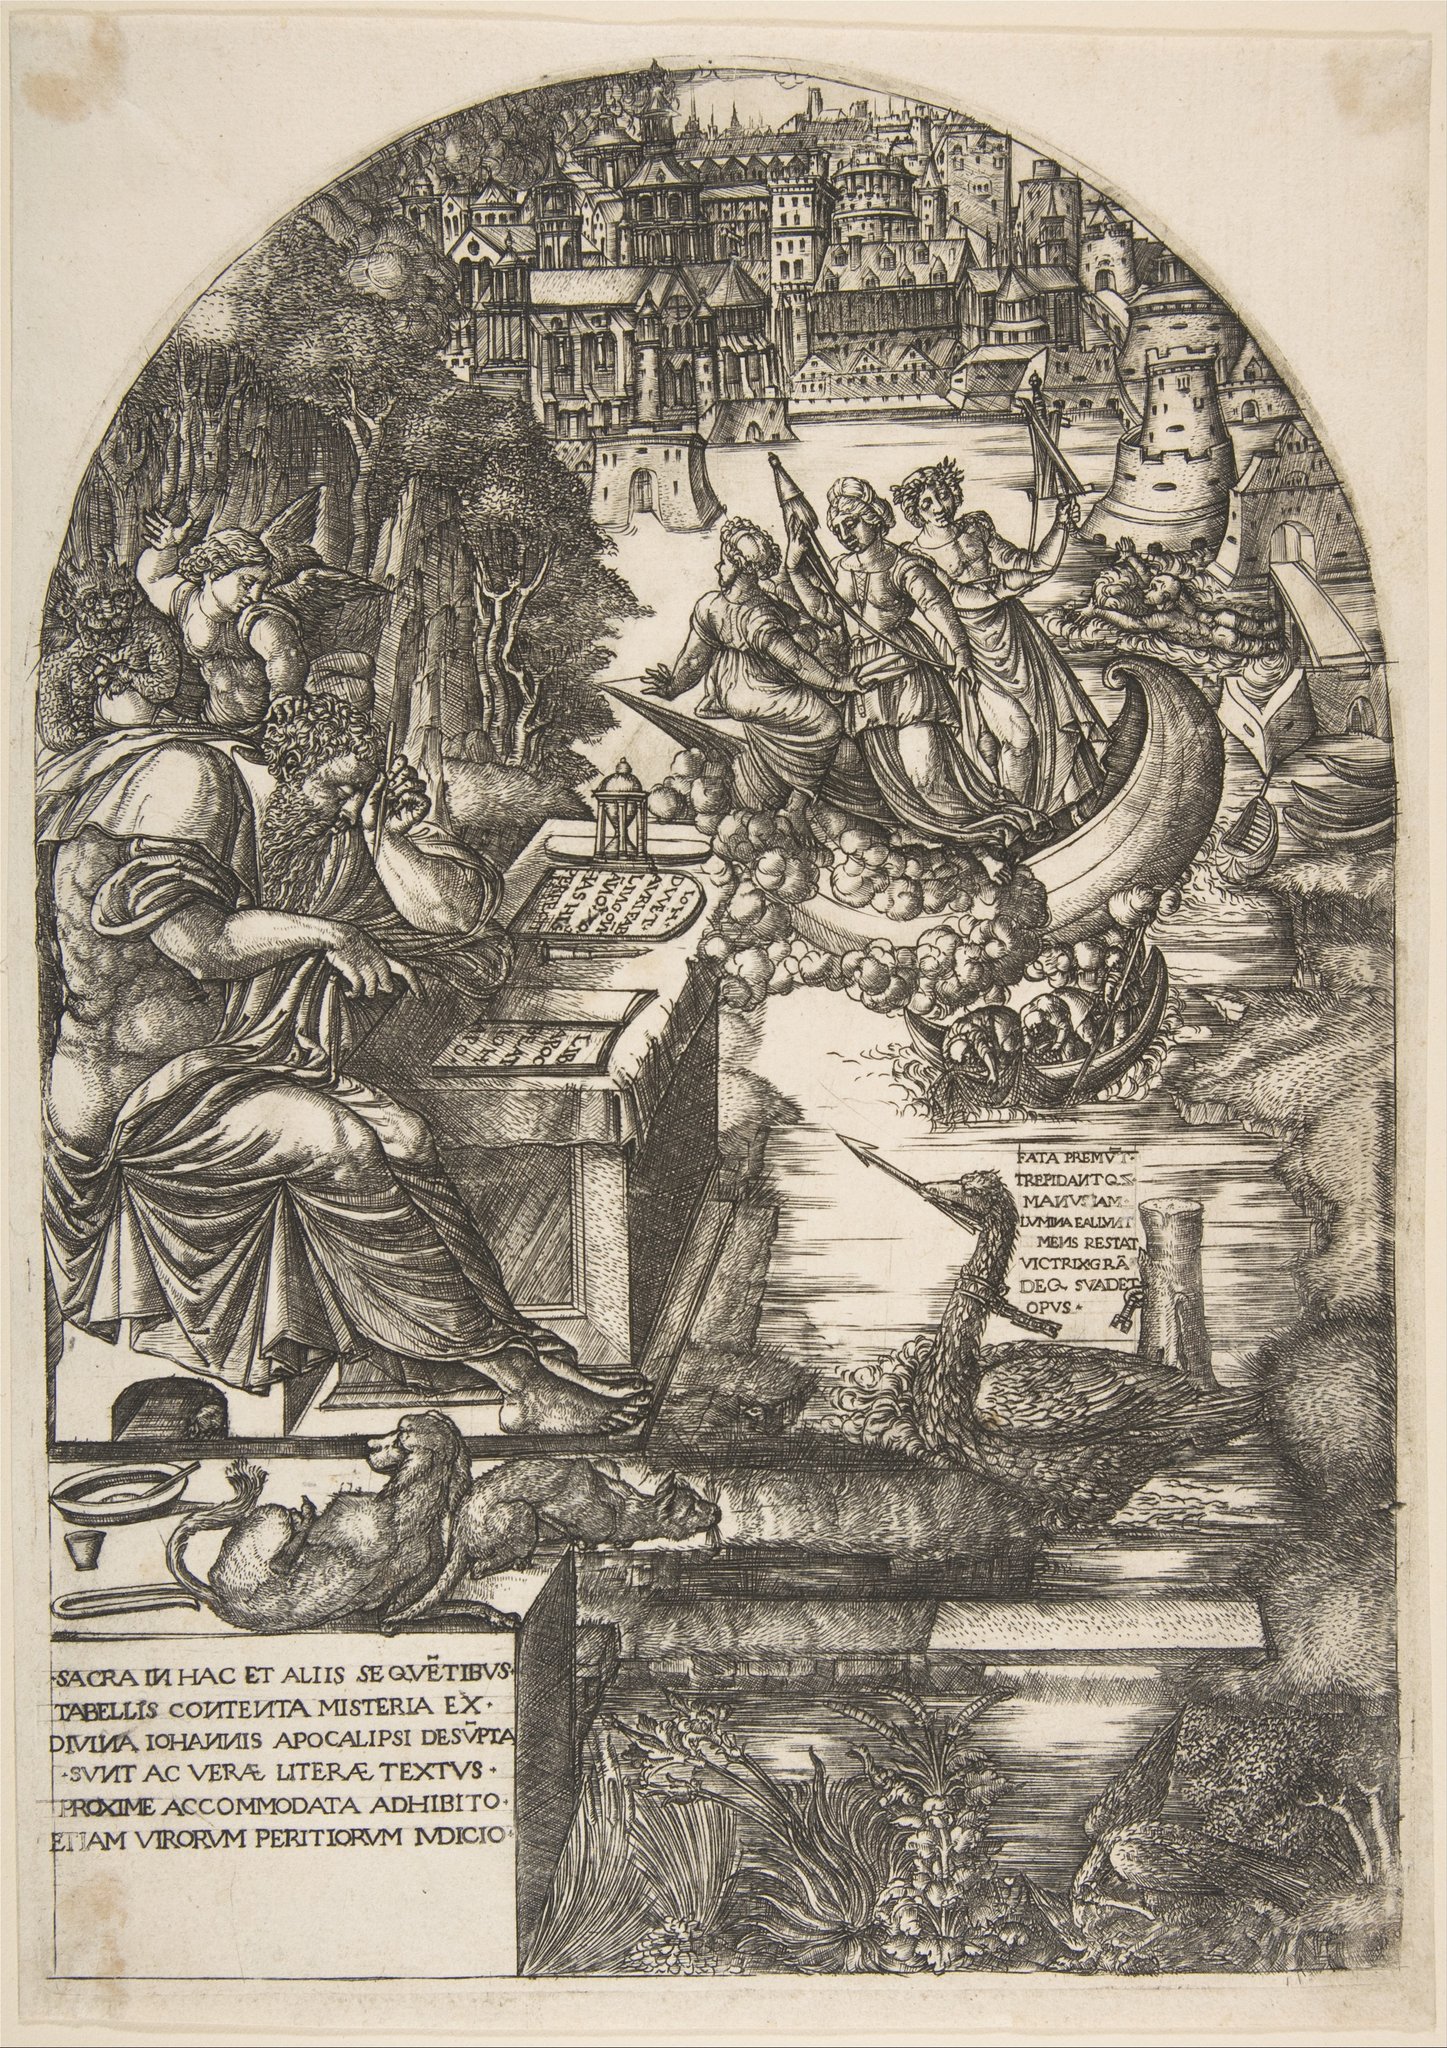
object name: print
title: The artist Jean Duvet in the guise of St. John the Evangelist, sitting at a desk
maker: jean duvet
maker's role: artist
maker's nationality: french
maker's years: 1485-1561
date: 1546-1555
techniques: engraving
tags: birds,men,women,saint john the evangelist,boats